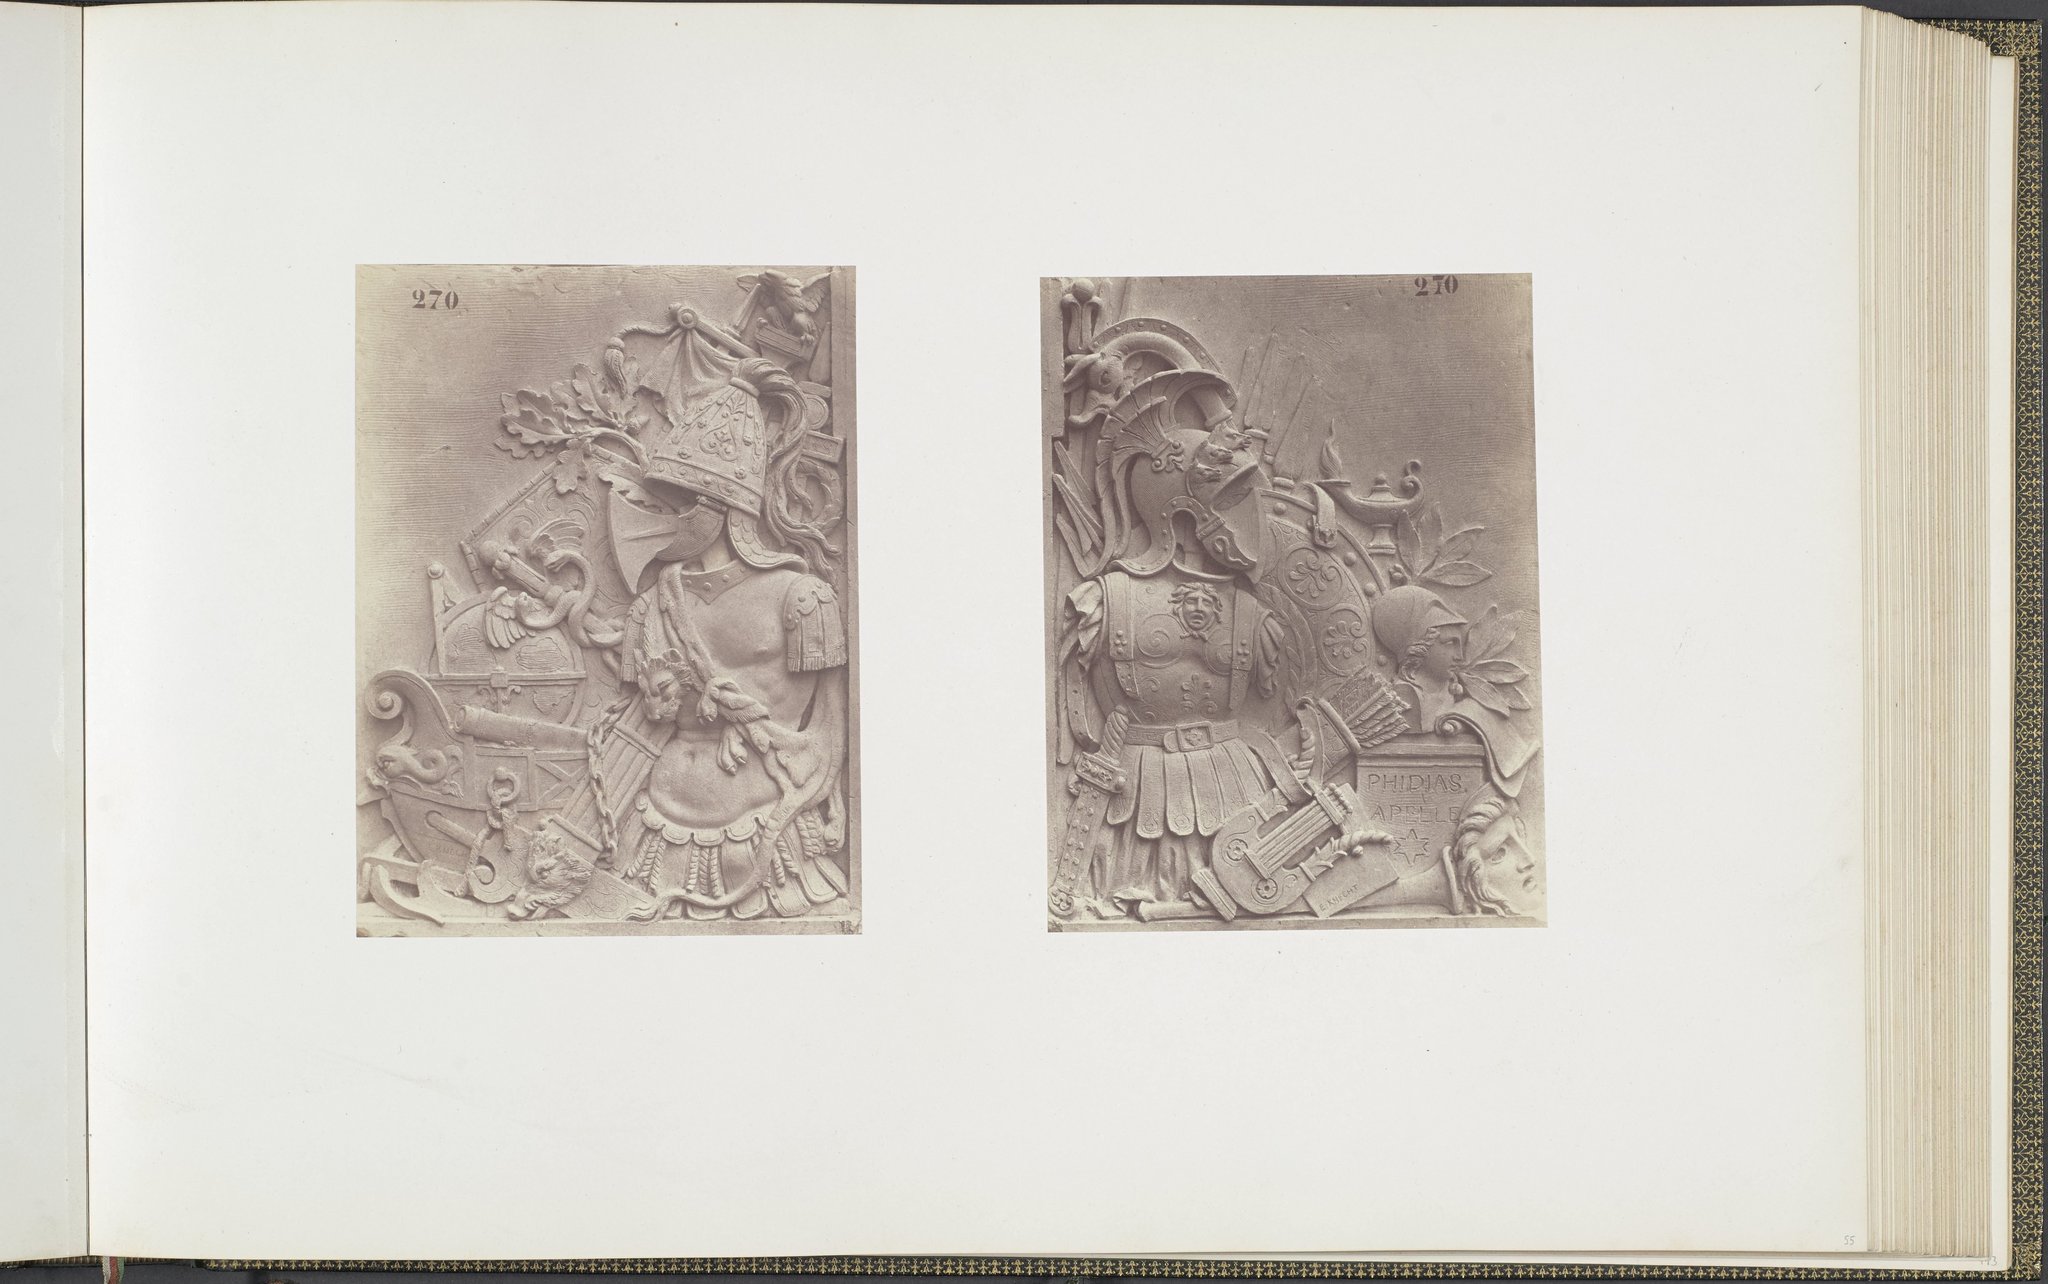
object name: album leaf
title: Gipsmodellen voor versieringen op het Palais du Louvre door Emile Knecht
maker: édouard denis baldus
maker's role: fotograaf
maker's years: 1813-1889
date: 1855-1857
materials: paper, photographic support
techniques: salted paper print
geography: paris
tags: permanent exhibition, museum, ornamenting, decorating ~ applied arts, paris, tuileries palace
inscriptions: number: ‘270’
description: Onderdeel van Réunion des Tuileries au Louvre 1852-1857, album 1.